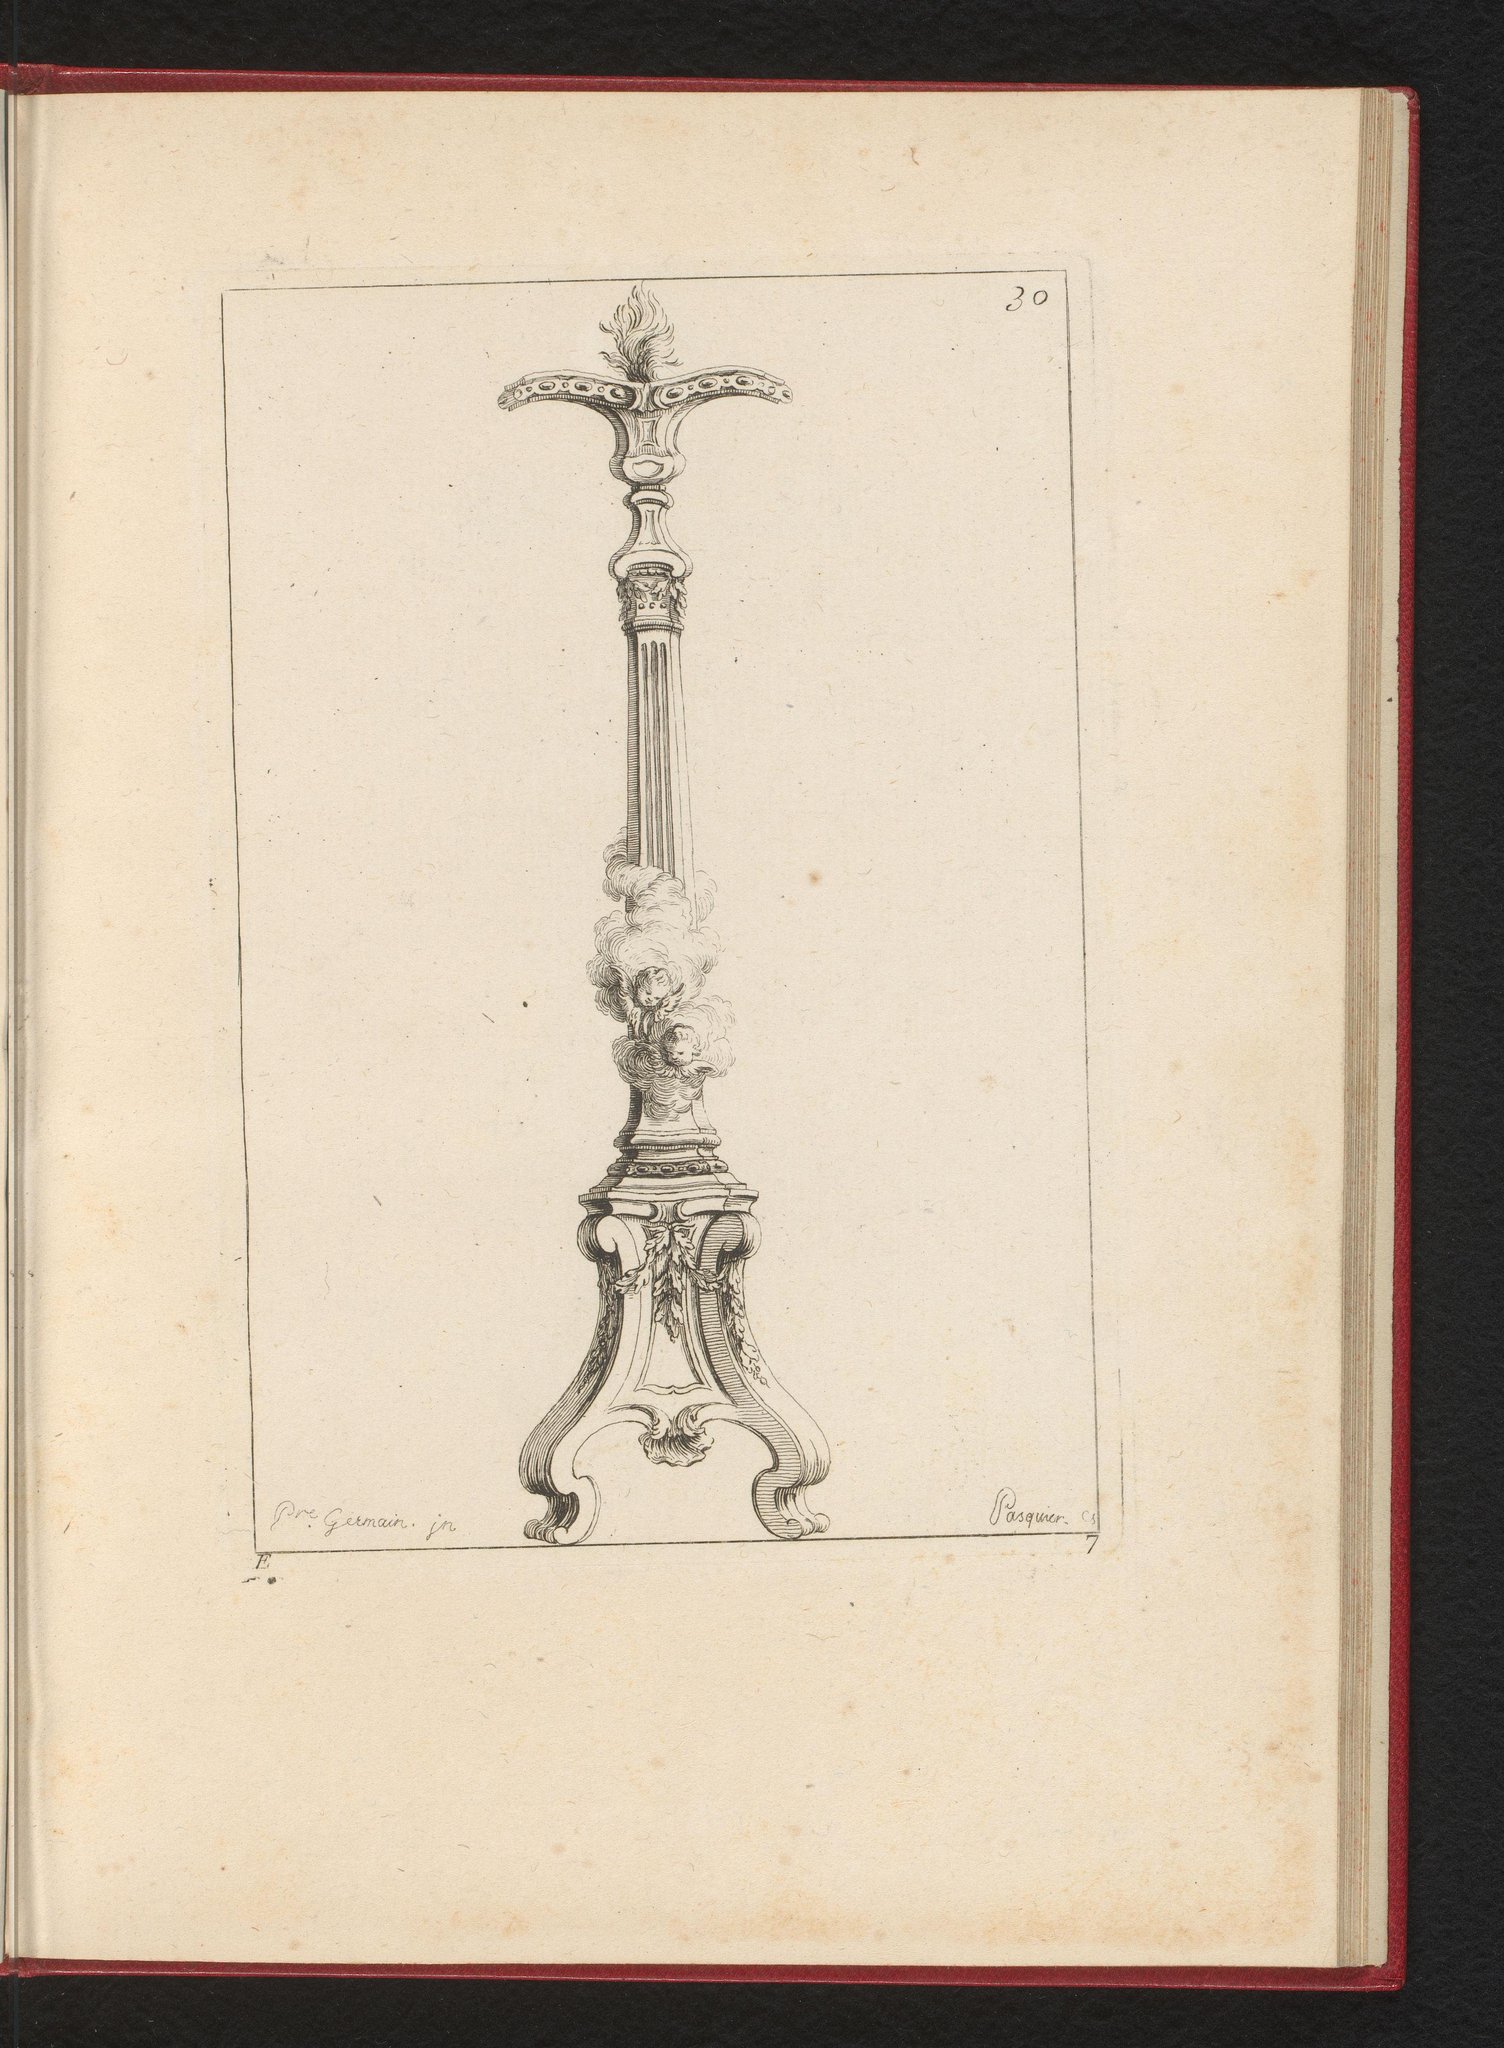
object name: album leaf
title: Elements d'orfevrerie divisés en deux parties de cinquante feuilles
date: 1748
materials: paper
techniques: etching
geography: paris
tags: candlesticks and candles, e.g. easter-candlestick, jeweller, goldsmith, silversmith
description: Vlak boven de voet gedecoreerd met twee cherubijnen in een wolk. Deze prent maakt deel uit van een album.